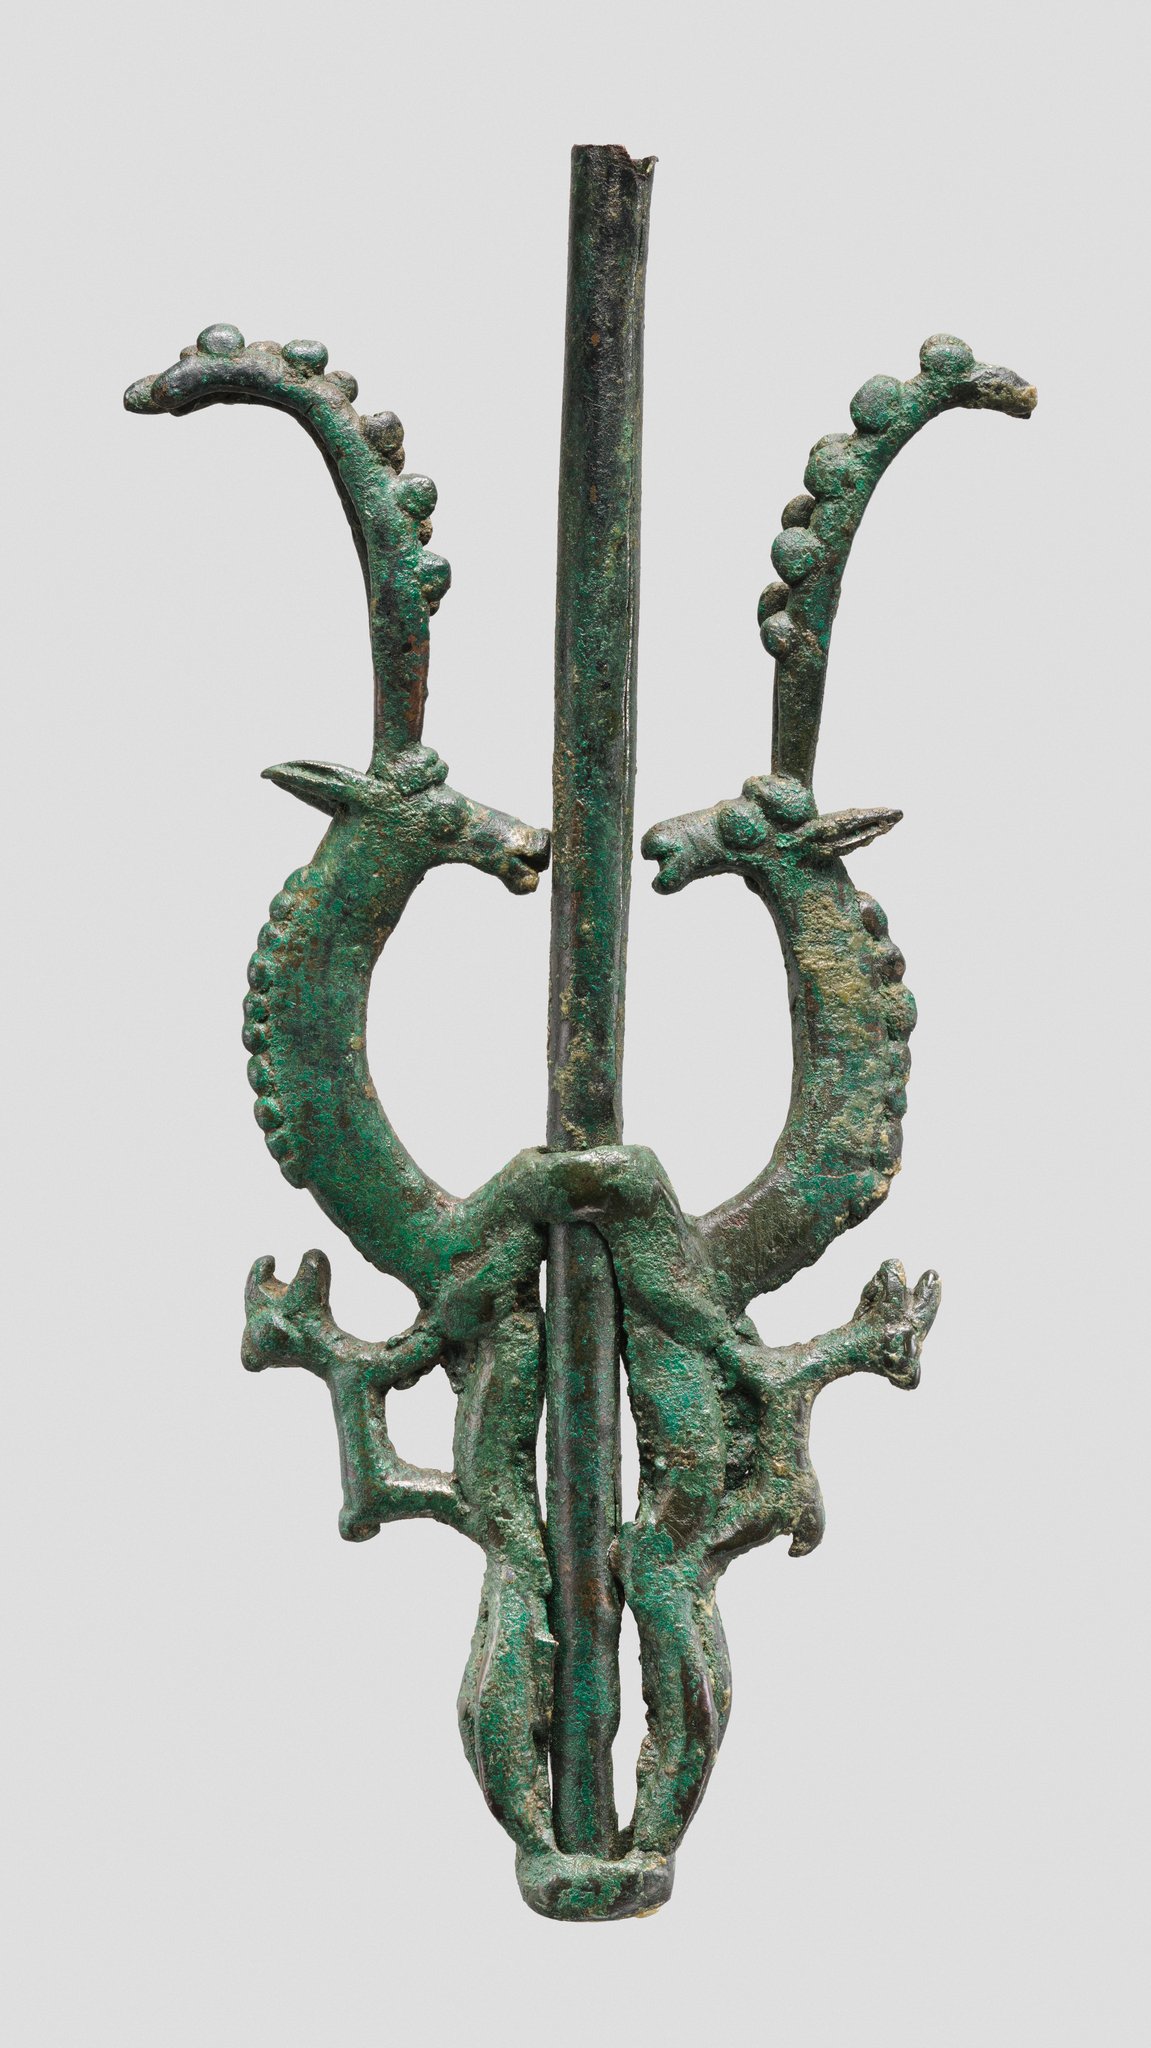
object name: standard top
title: Top for standard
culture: iranian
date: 900-701 BCE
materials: bronze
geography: iran, probably from luristan